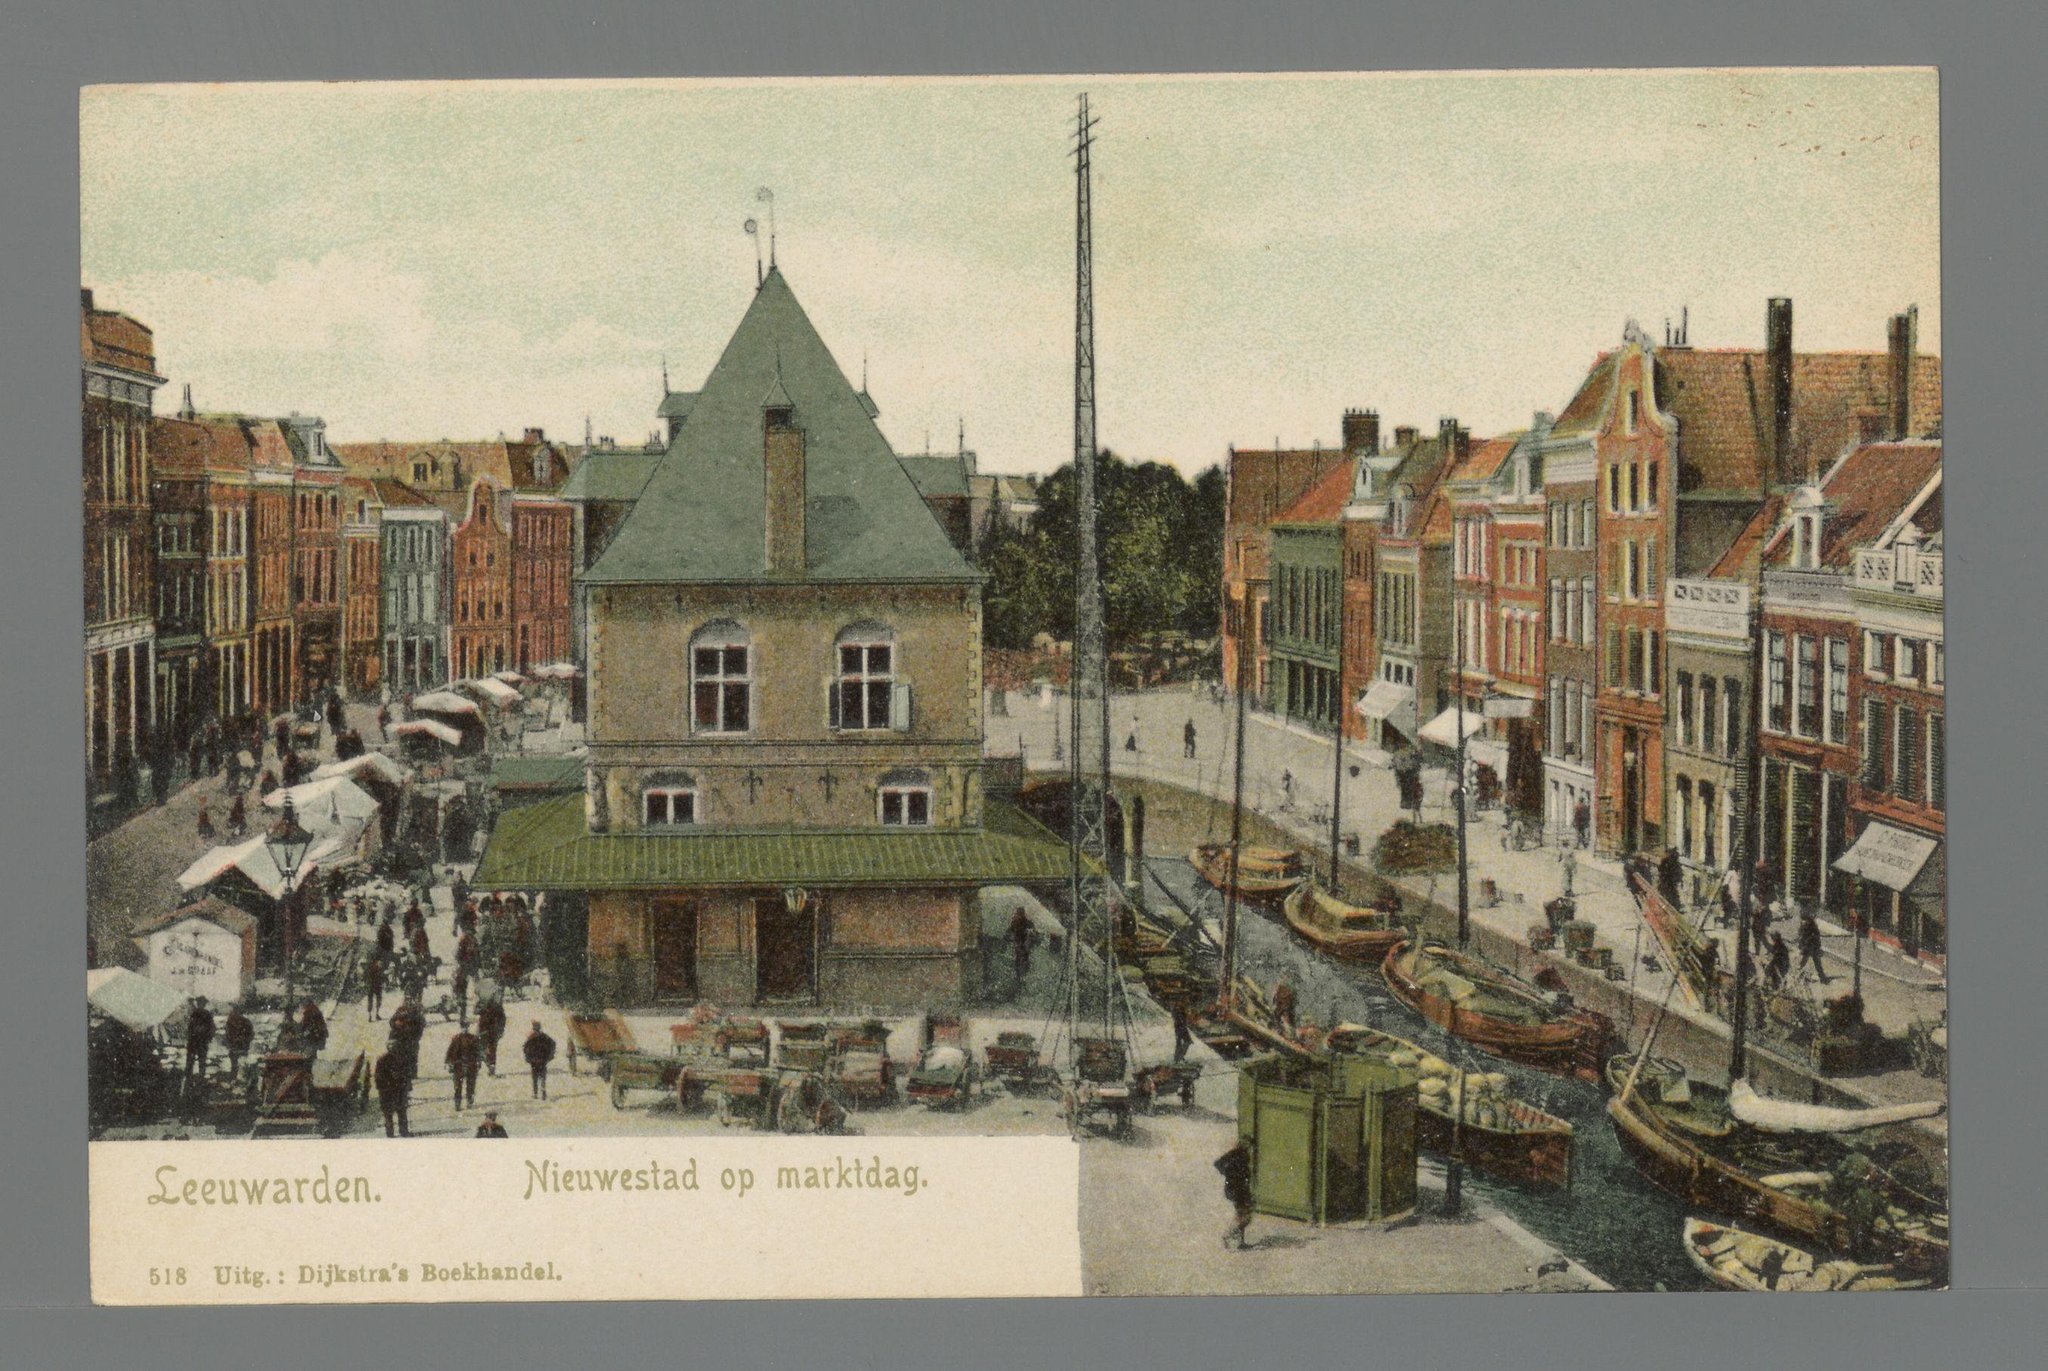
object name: photomechanical print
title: Leeuwarden. Nieuwestad op marktdag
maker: Anonymous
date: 1892-1905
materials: cardboard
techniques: photograph, lithograph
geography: leeuwarden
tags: sailing-ship, sailing-boat, canal, market, street